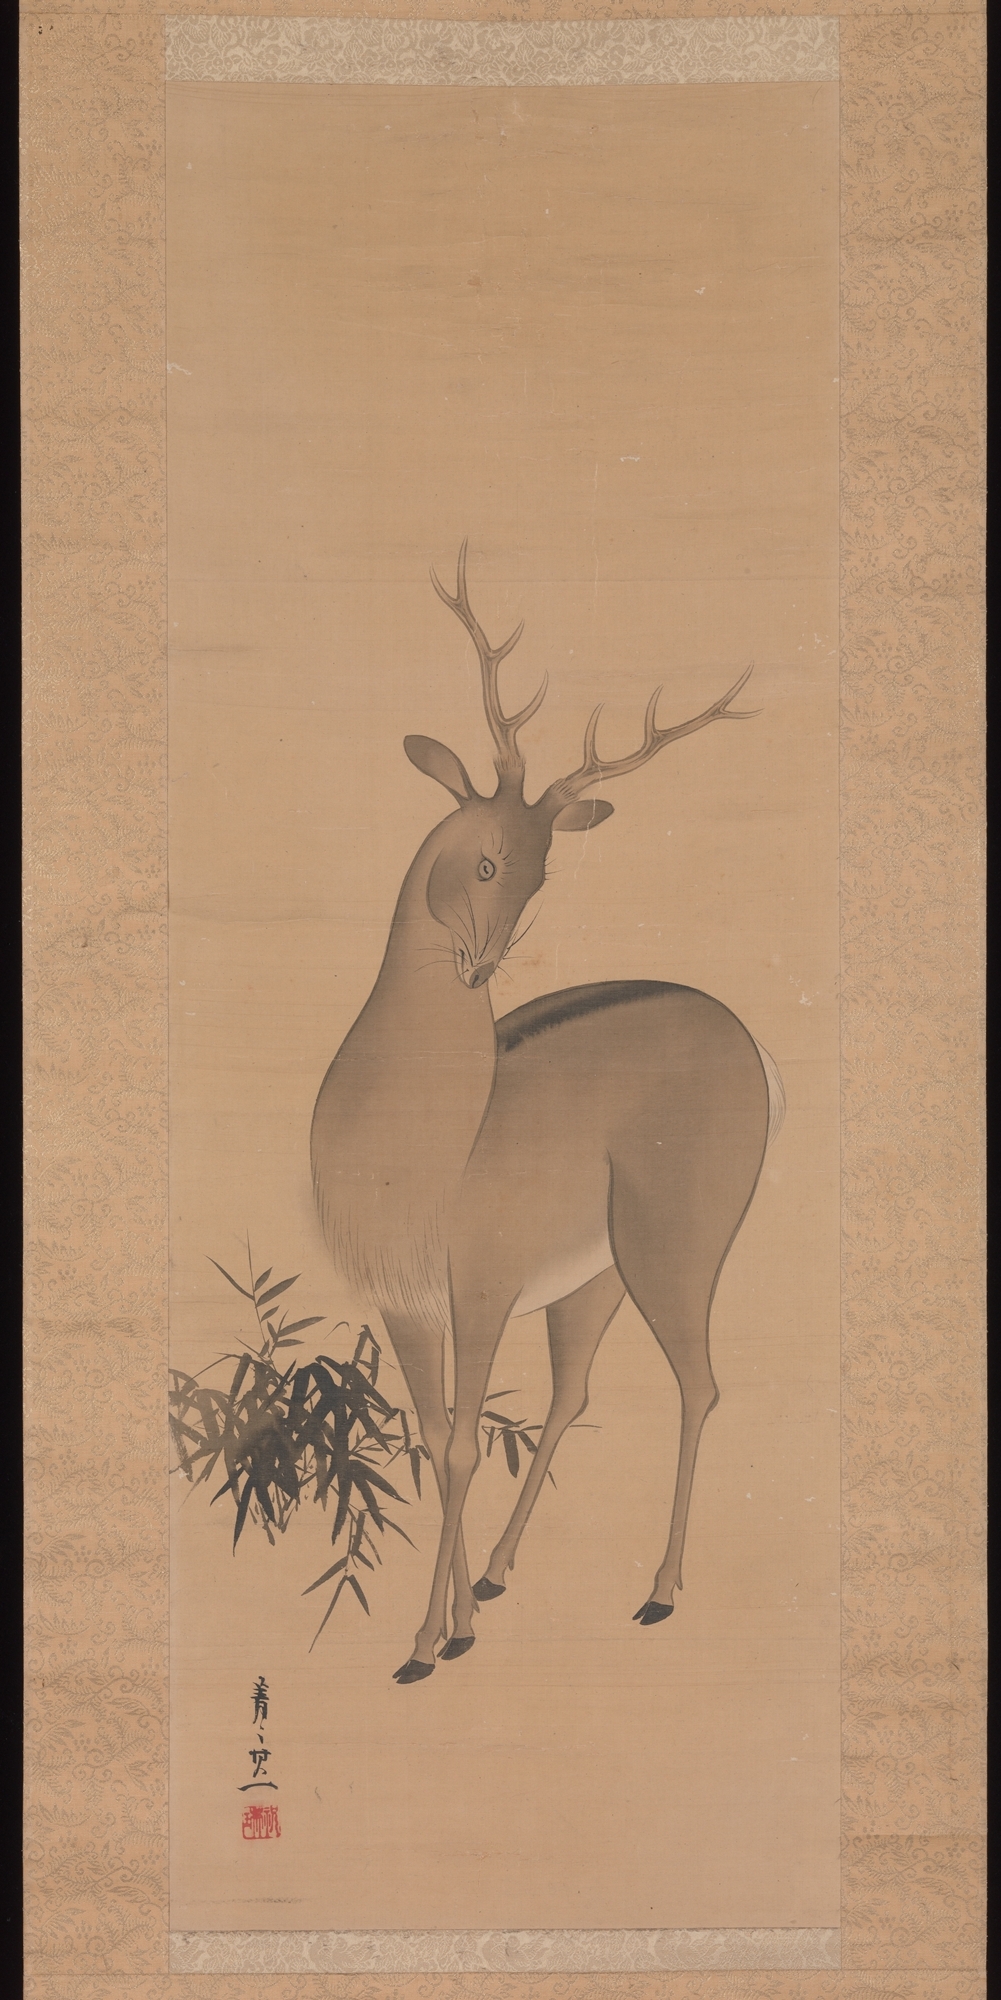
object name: hanging scroll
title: Deer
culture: japanese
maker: suzuki kiitsu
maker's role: artist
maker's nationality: japanese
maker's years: 1796-1858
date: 1801-1900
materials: ink, silk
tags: deer